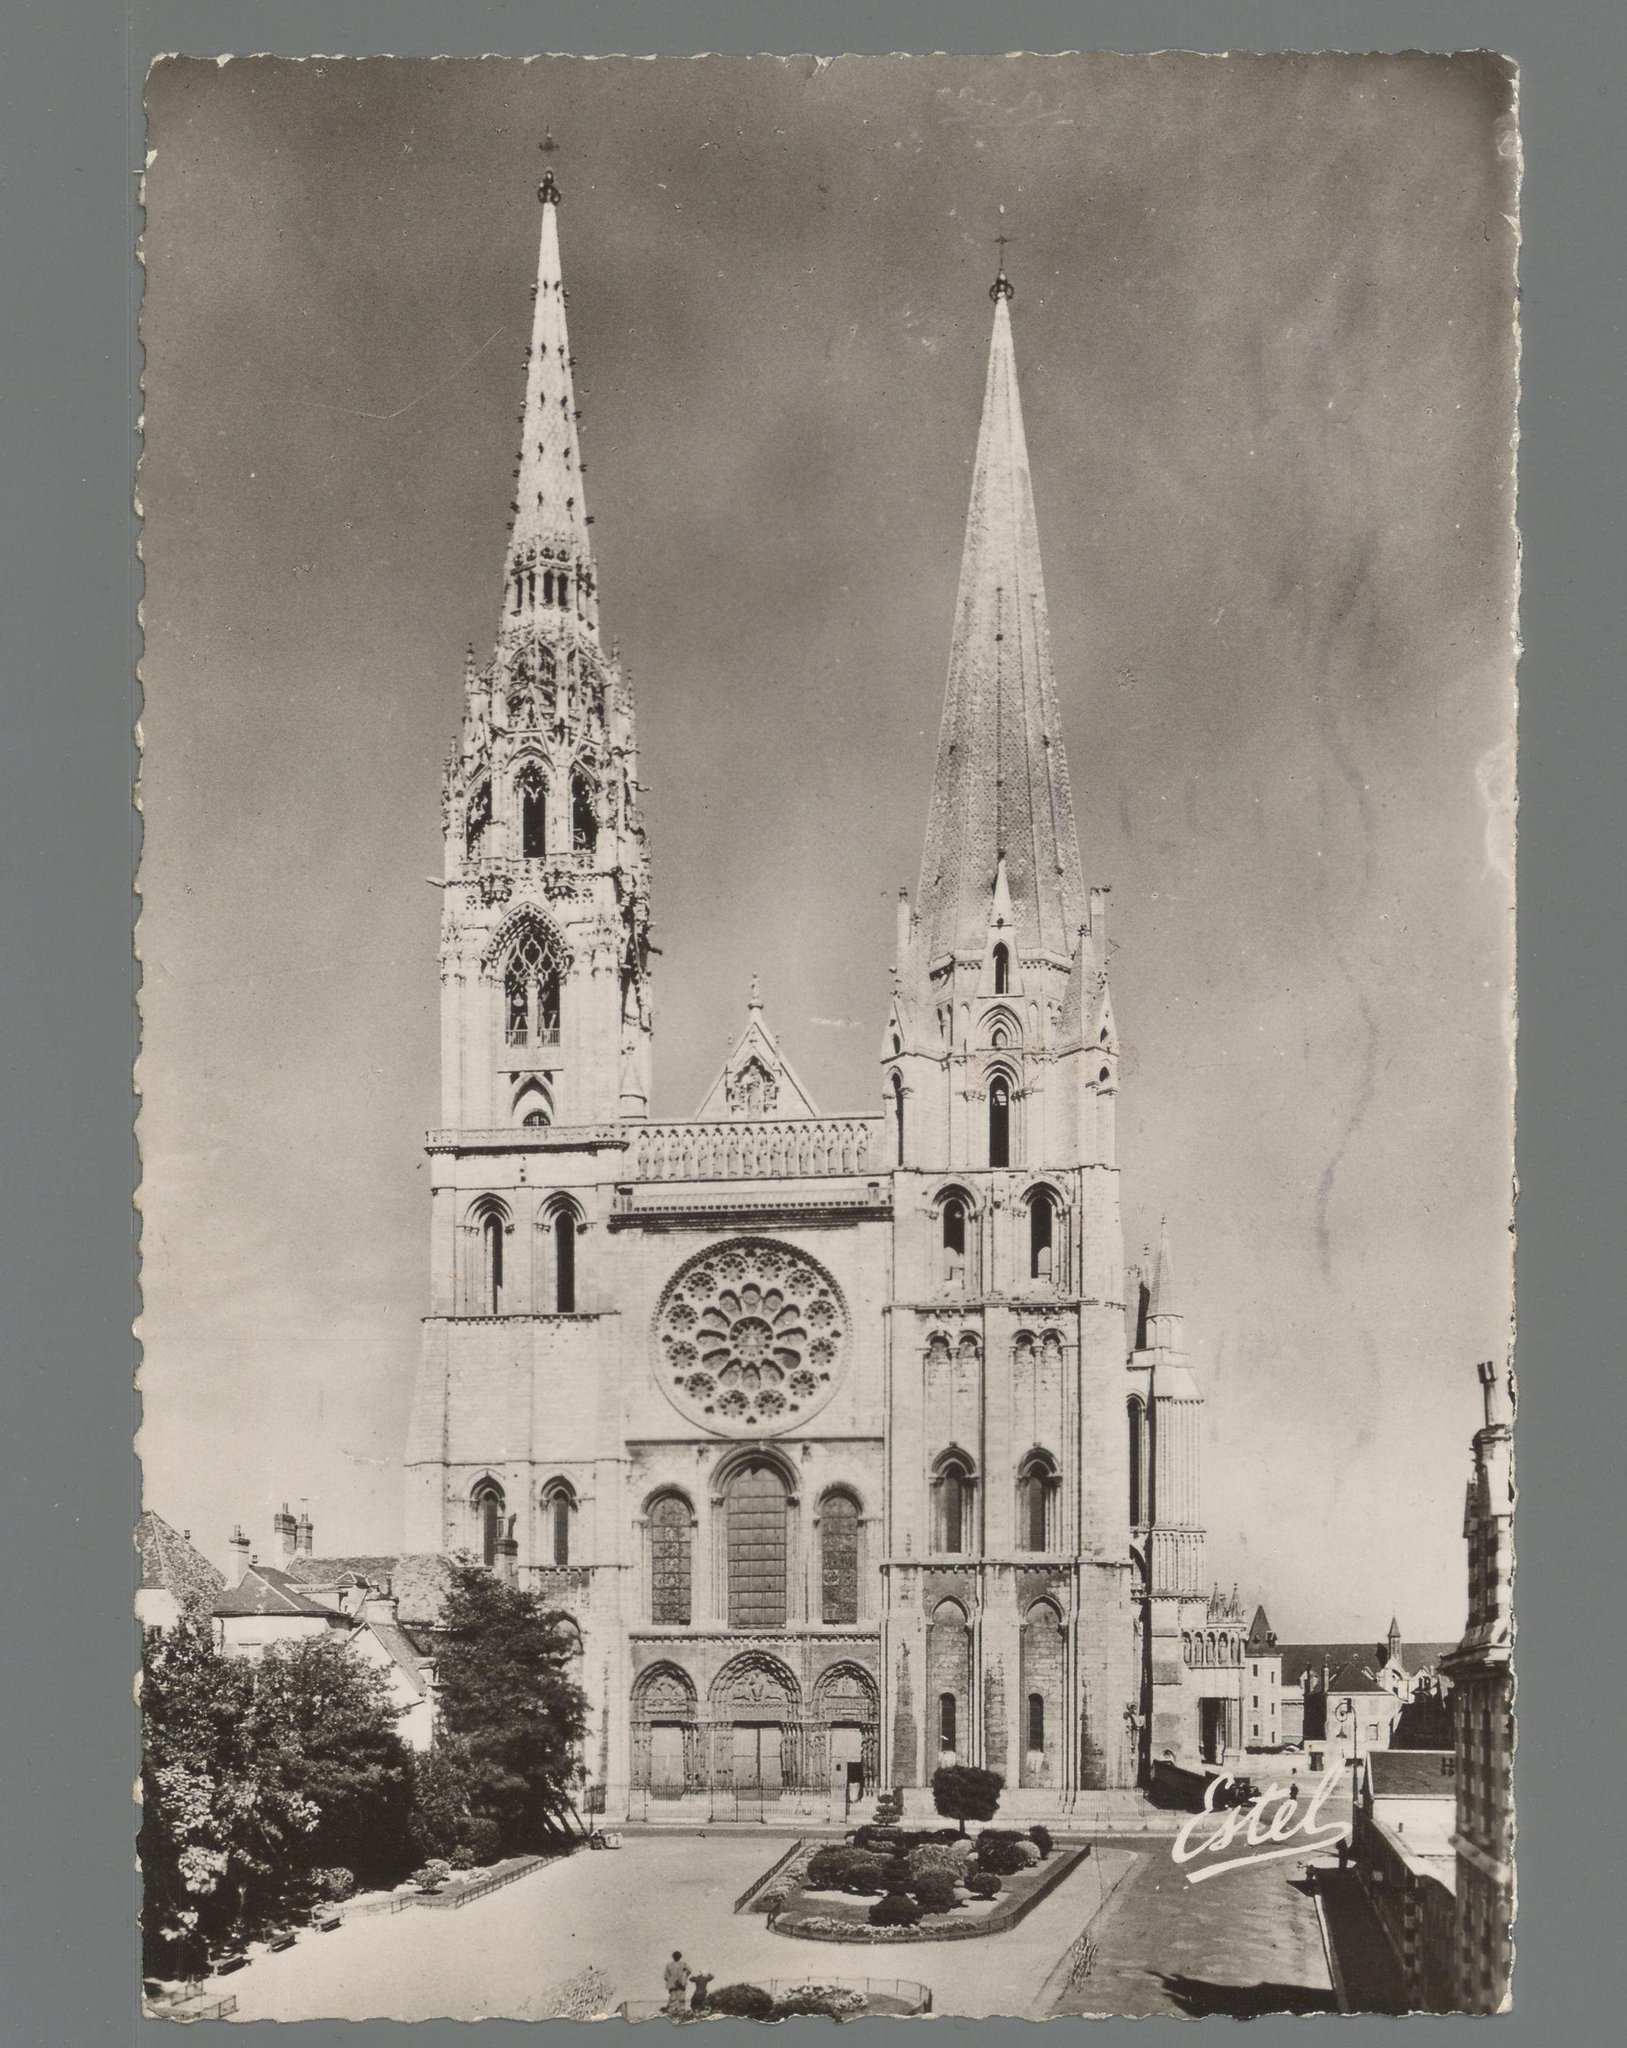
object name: photograph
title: La Cathédrale de Chartres. La façade principale / The chief front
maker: Anonymous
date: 1929-1951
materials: photographic support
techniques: photography, writing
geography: paris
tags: square, place, circus, etc., church (exterior)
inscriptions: poststempel, verso, gestempeld